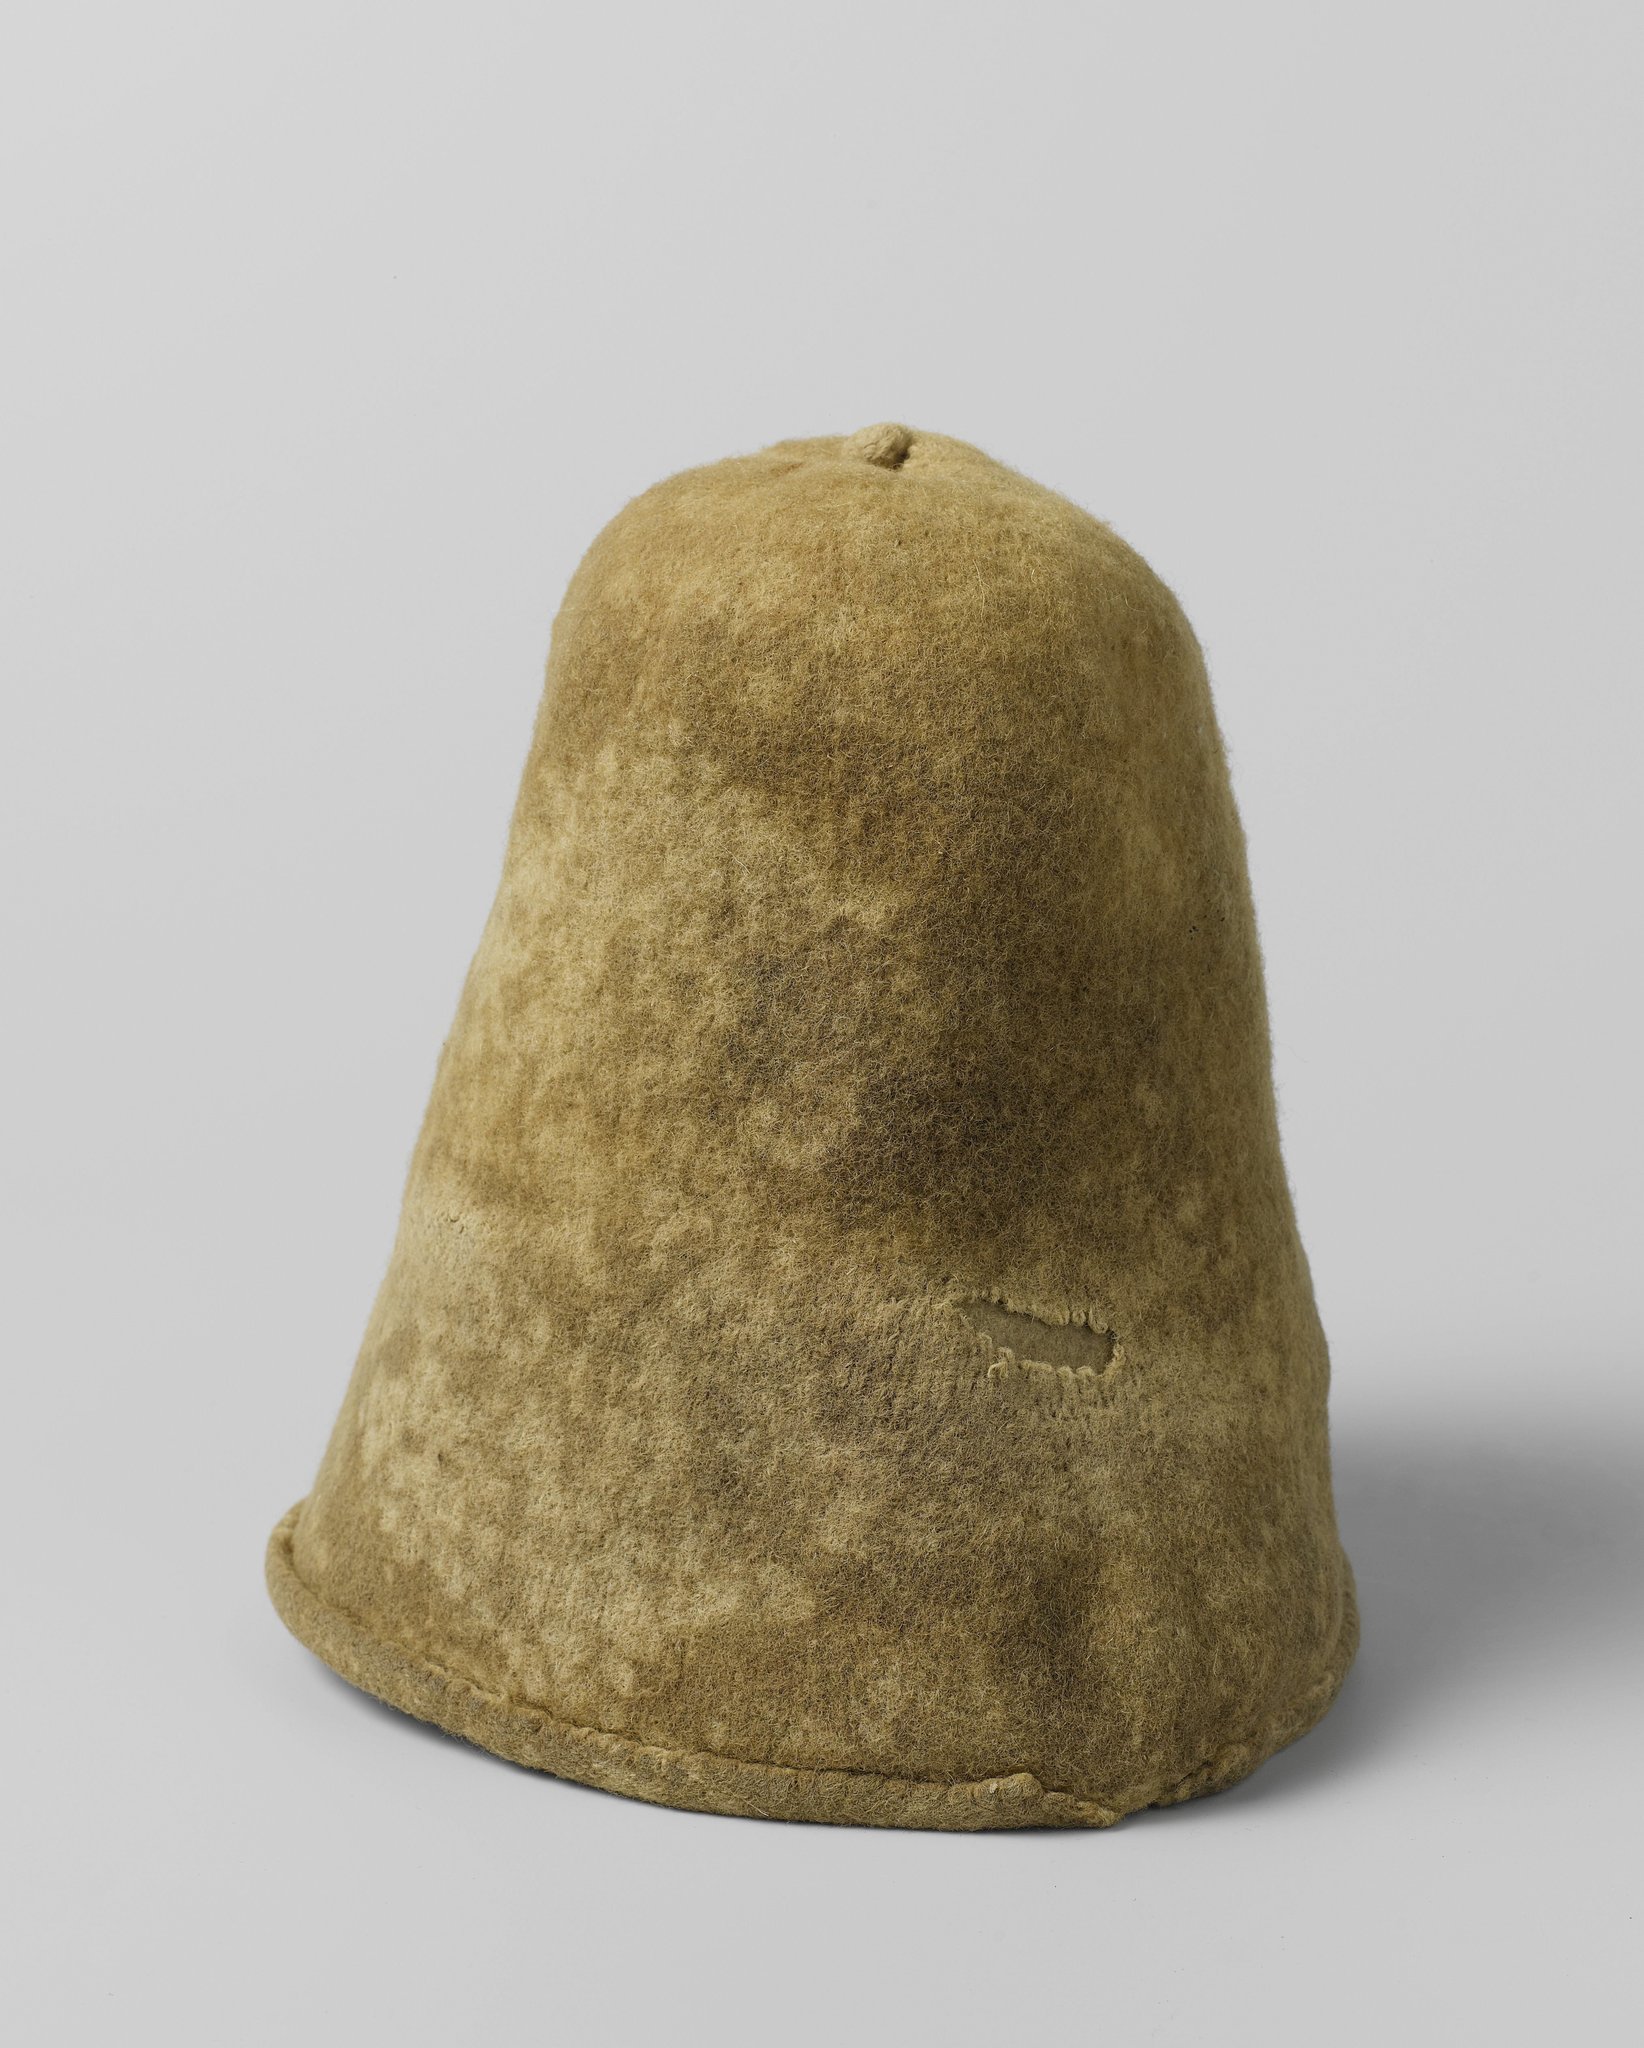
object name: cap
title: Woollen caps worn by Dutch whalers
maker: Anonymous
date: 1650-1700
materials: wool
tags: noordse compagnie, spitsbergen, zeeuwsche uytkyck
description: In 1980 archaeologists investigated the graves of 185 Dutchmen – whale hunters and workmen of the train oil refineries – who had died on or near Spitsbergen during the 17th century. The skeletons were still wearing their knitted woollen caps. Each cap was individualized; the men recognized one another only by the pattern of stripes on the caps. The men were bundled up so tightly against the fierce cold that only their eyes were visible.